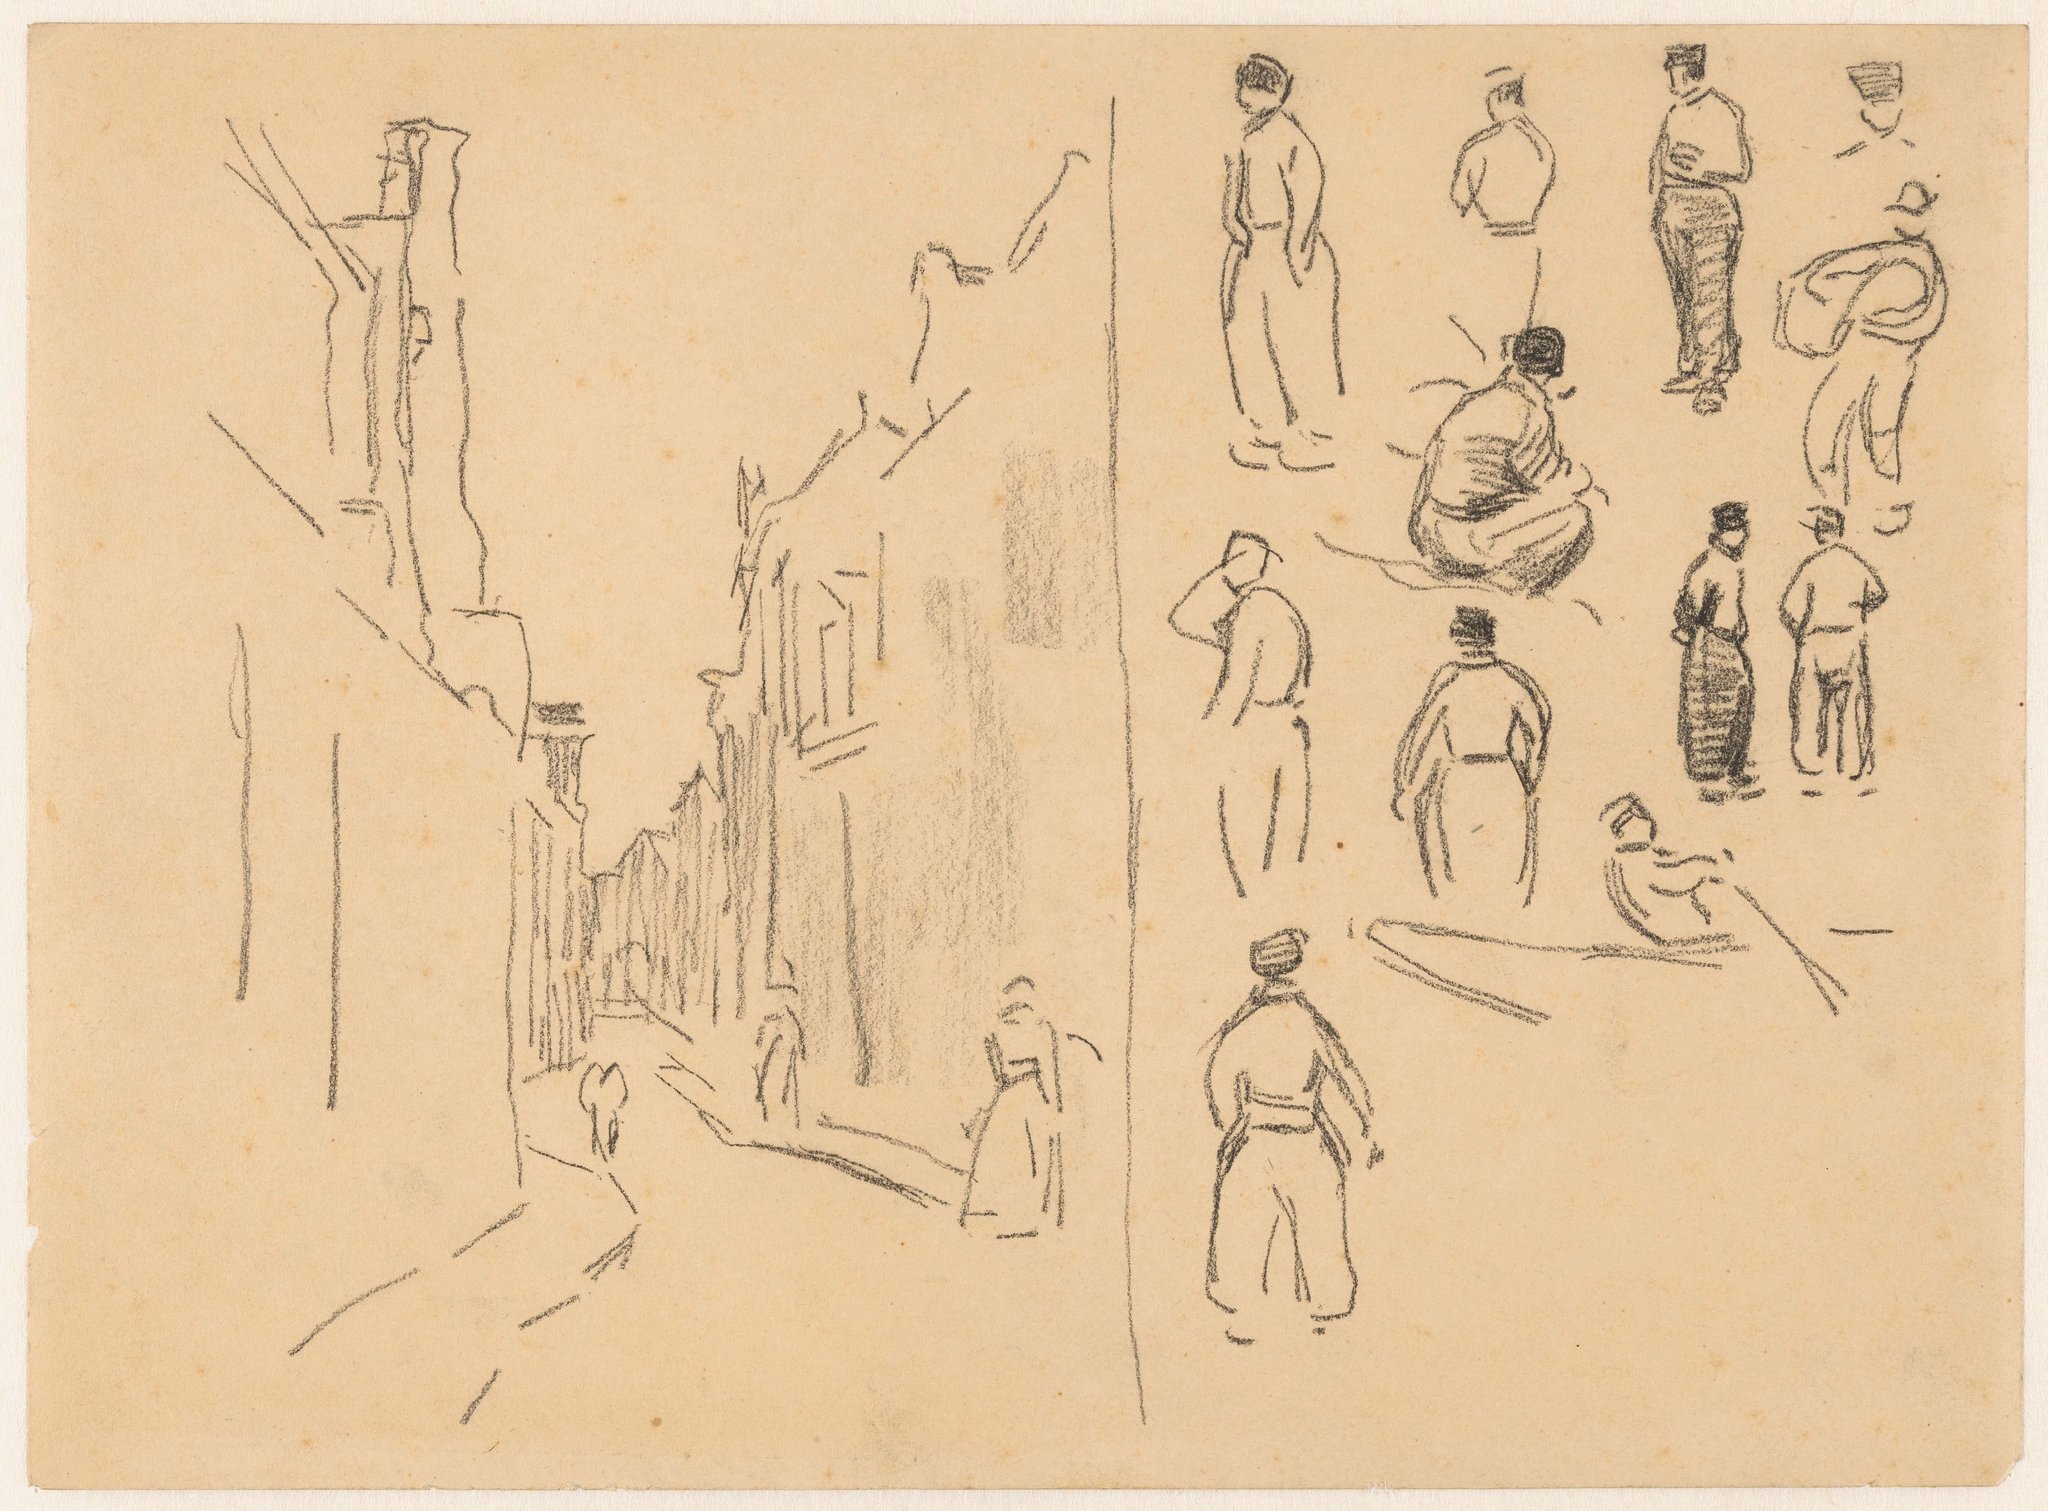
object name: drawing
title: Studieblad met op de ene helft een straat en op de ander diverse figuurstudies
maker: willem bastiaan tholen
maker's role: draughtsman, painter, print maker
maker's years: 1860-1931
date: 1870-1931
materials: chalk, paper